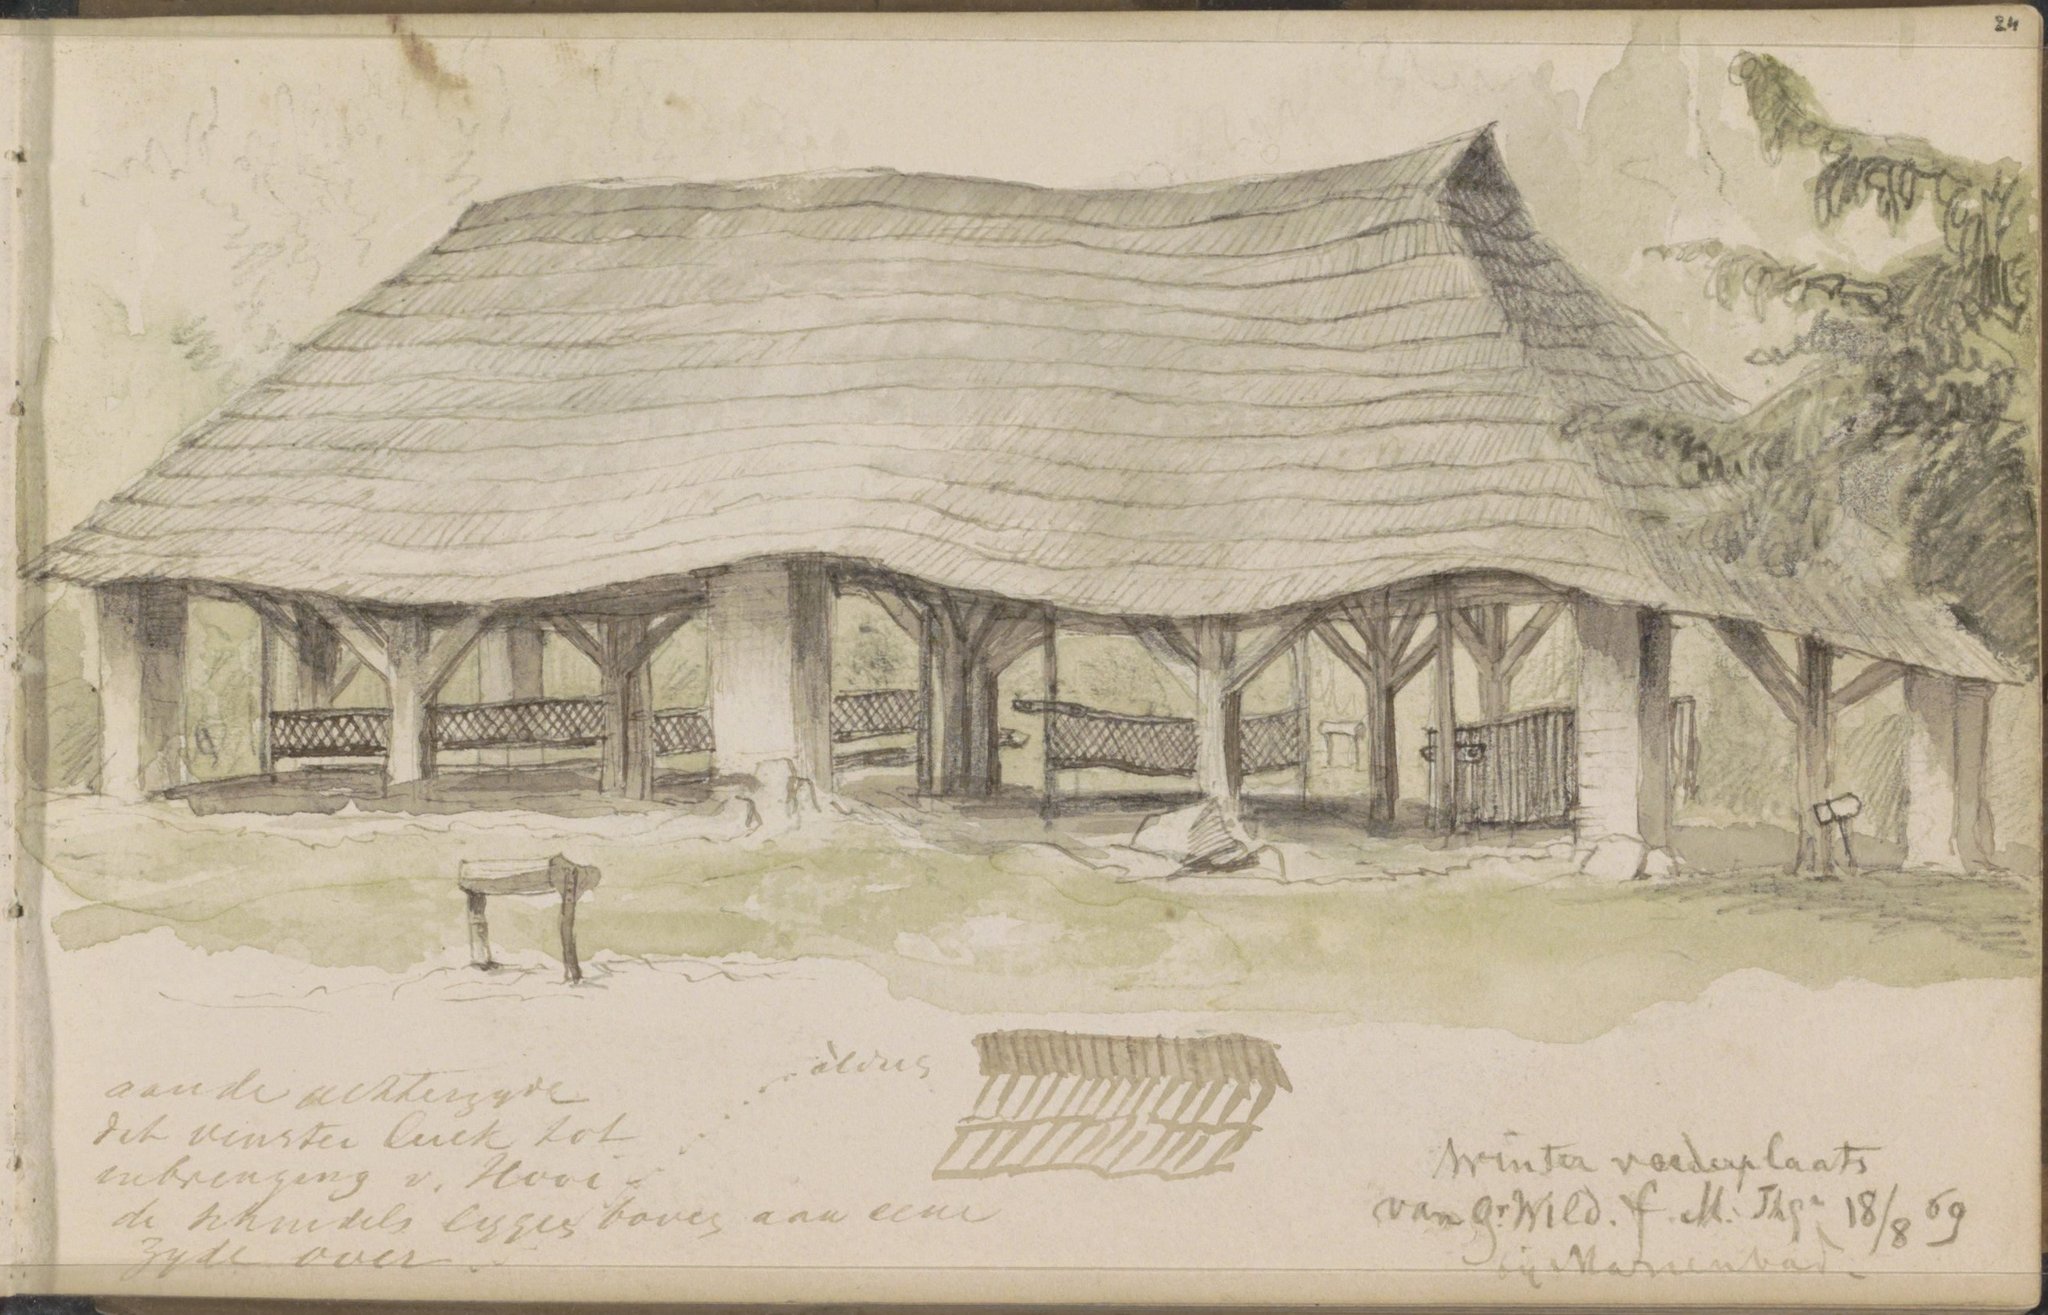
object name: sketchbook leaf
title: Wintervoederplaats voor wilde dieren in Marienbad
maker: johannes tavenraat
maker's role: draughtsman, painter, print maker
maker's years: 1809-1881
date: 1808-1869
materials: ink, paper, pencil, watercolor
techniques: brush, pen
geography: marienbad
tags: feeding wild animals in winter, marienbad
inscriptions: date and inscription: ‘winter voederplaats/ van gr wild. [...] 18/8 69/ bij Marienbad/ aan de achterzijde/ het venster luik tot/ inbrenging v. Hooi/ de [...] liggen boven aan een/ zijde over’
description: Tevens een studie van een vensterluik. Blad 24 recto uit een schetsboek met 48 bladen.